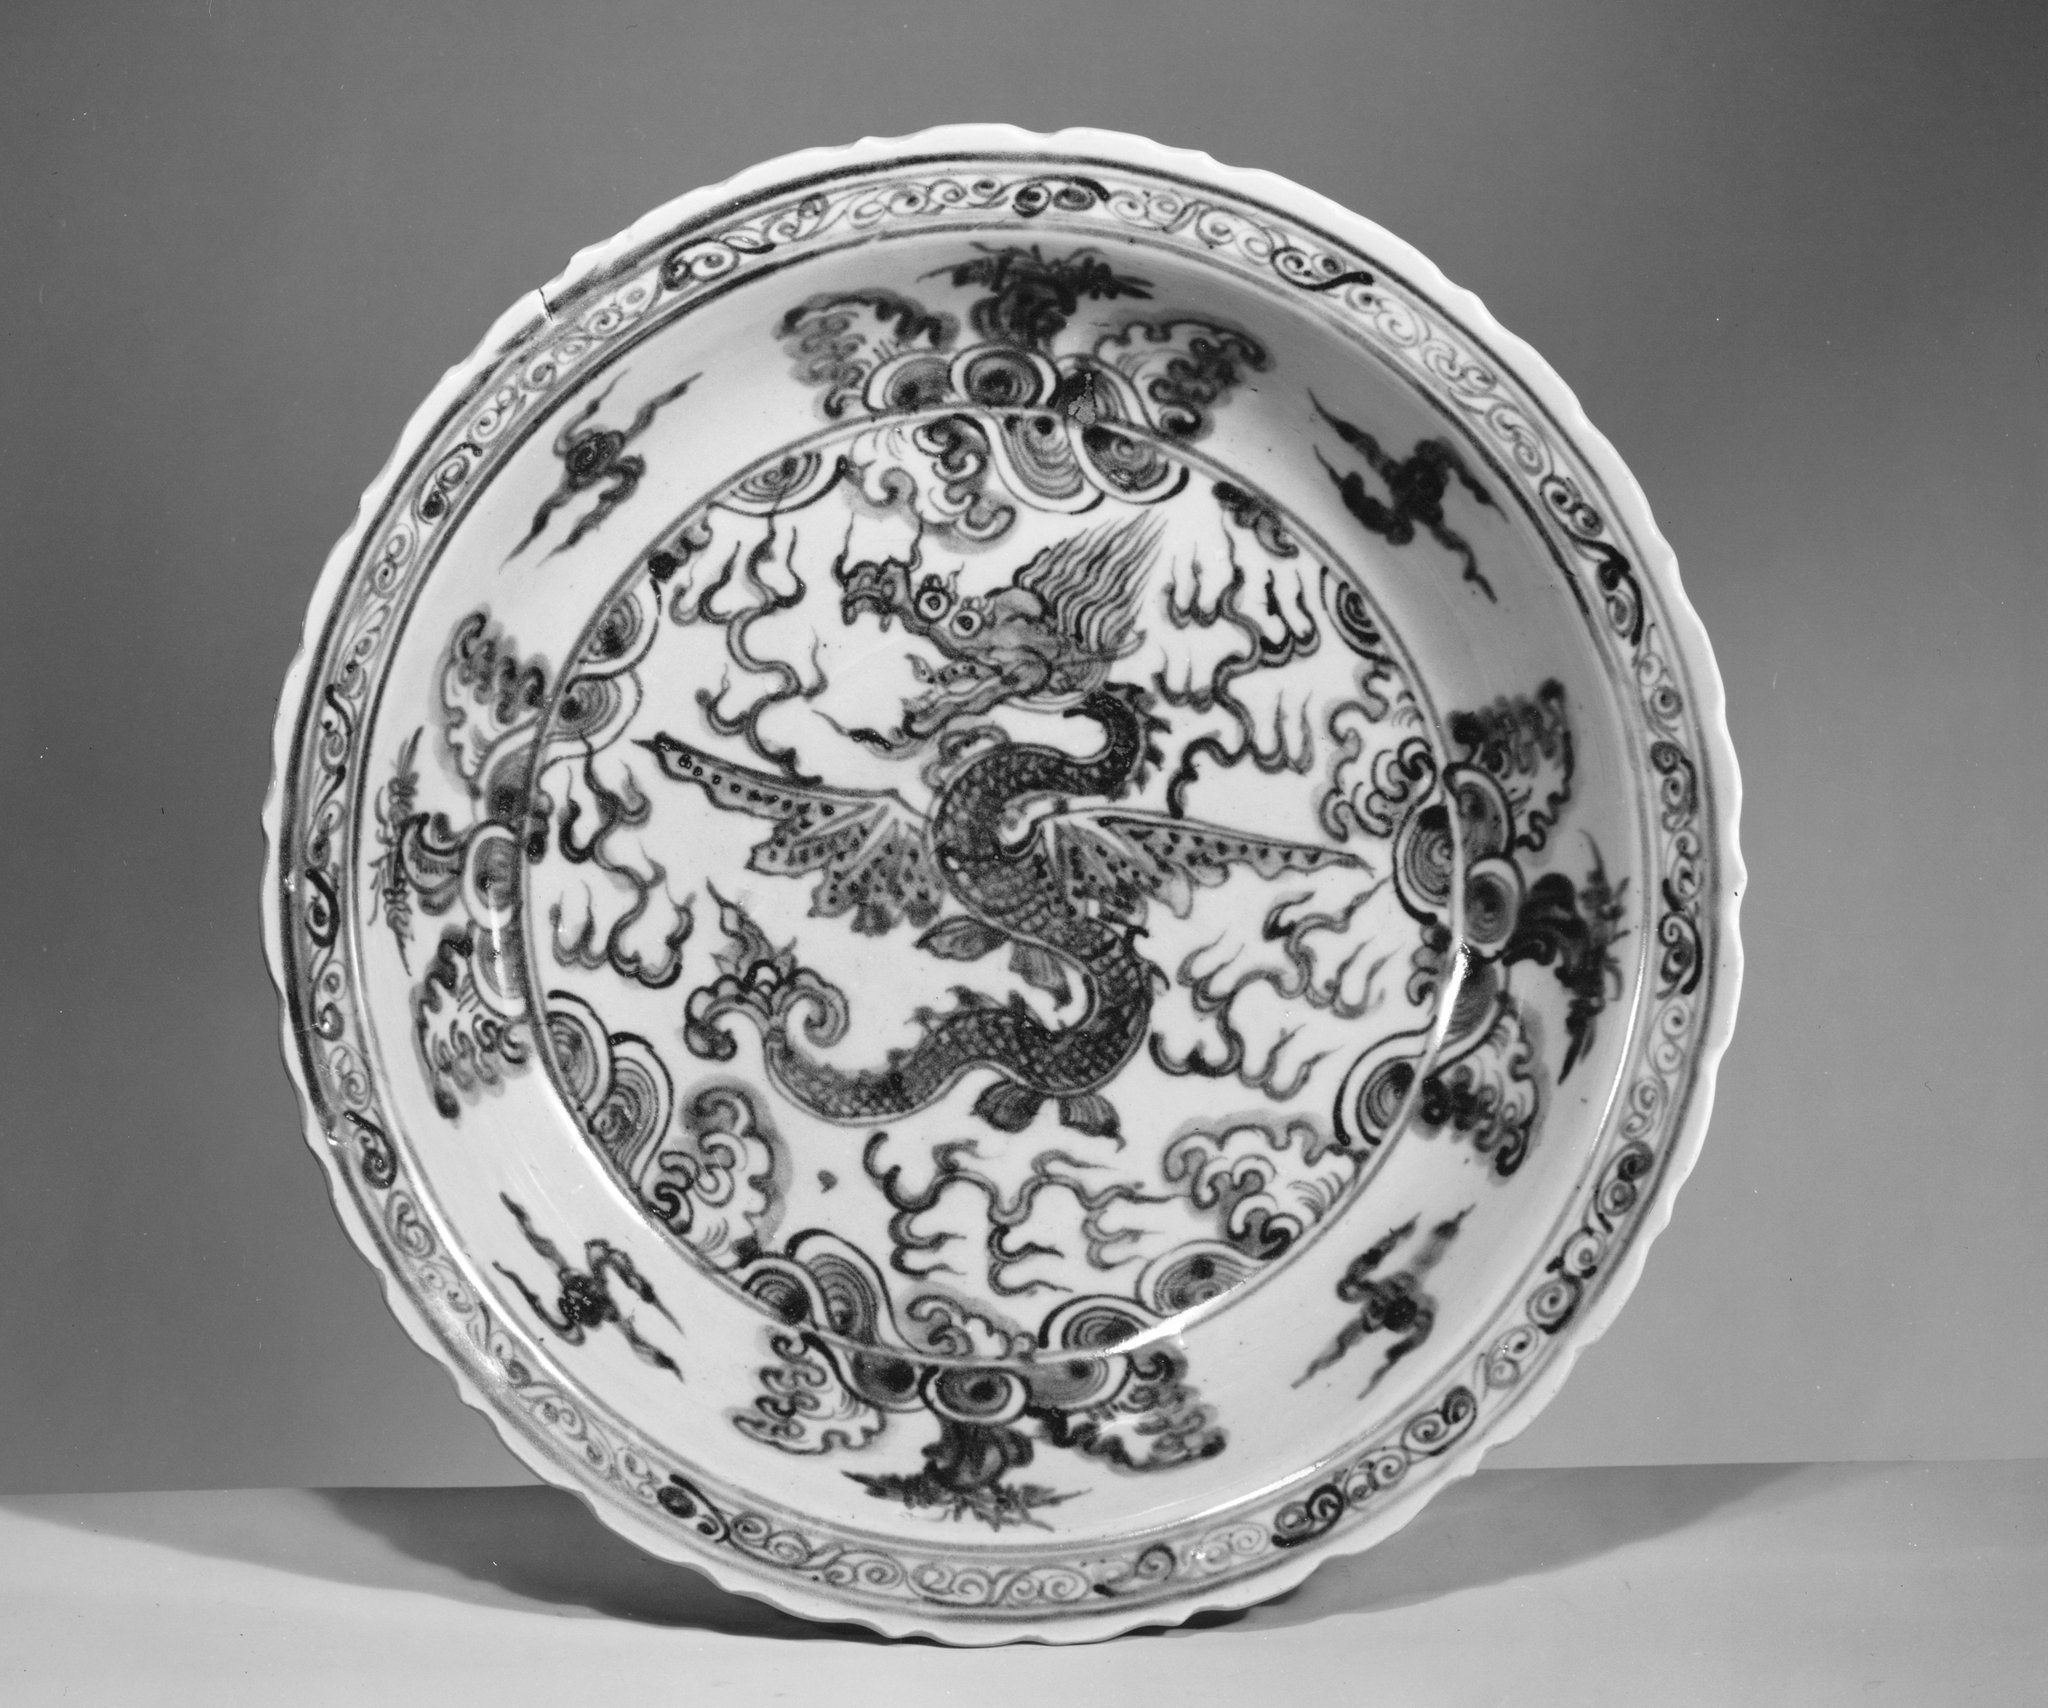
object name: plate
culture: chinese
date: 1526-1550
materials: porcelain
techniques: painting, underglaze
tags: dragons